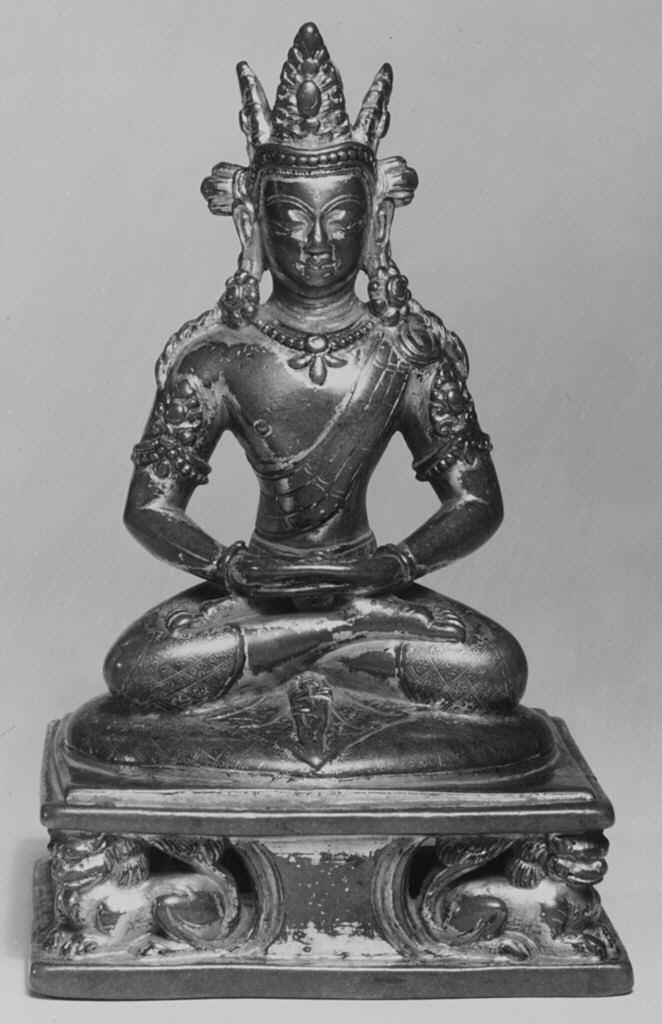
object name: figure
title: Manjushri, an Emanation of Amitabha Buddha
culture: nepali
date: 1001-1200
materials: copper alloy, gilt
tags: buddhism,buddha,manjushri